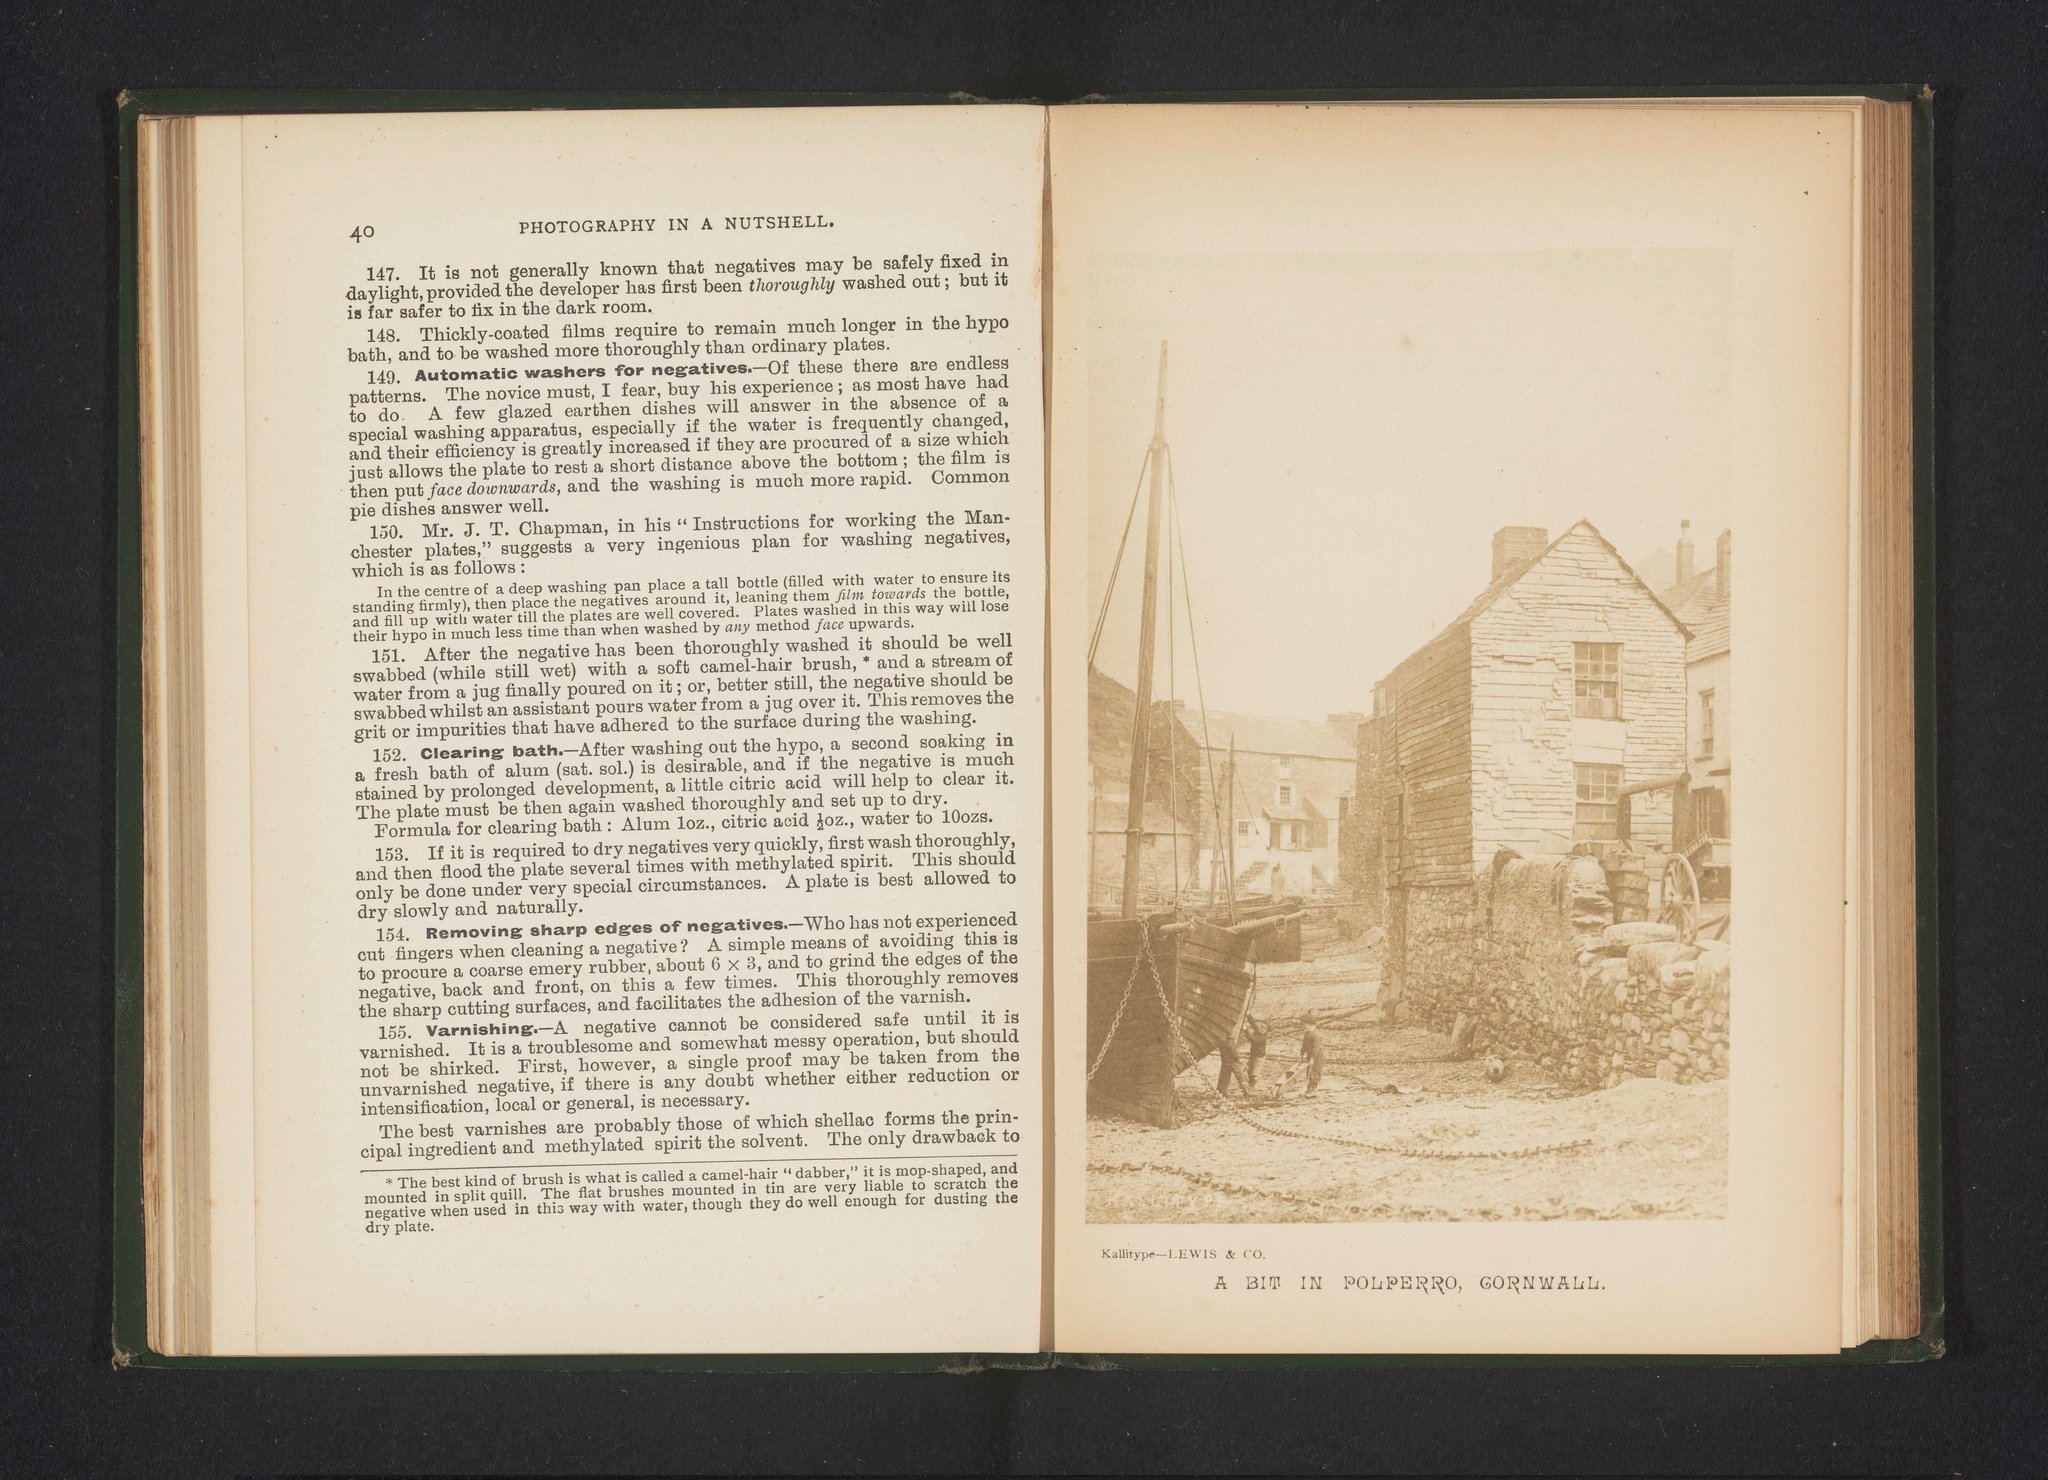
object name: page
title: A bit in Polerro, Cornwall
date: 1881-1891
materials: paper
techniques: kallitype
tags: building a ship, ship under construction, street